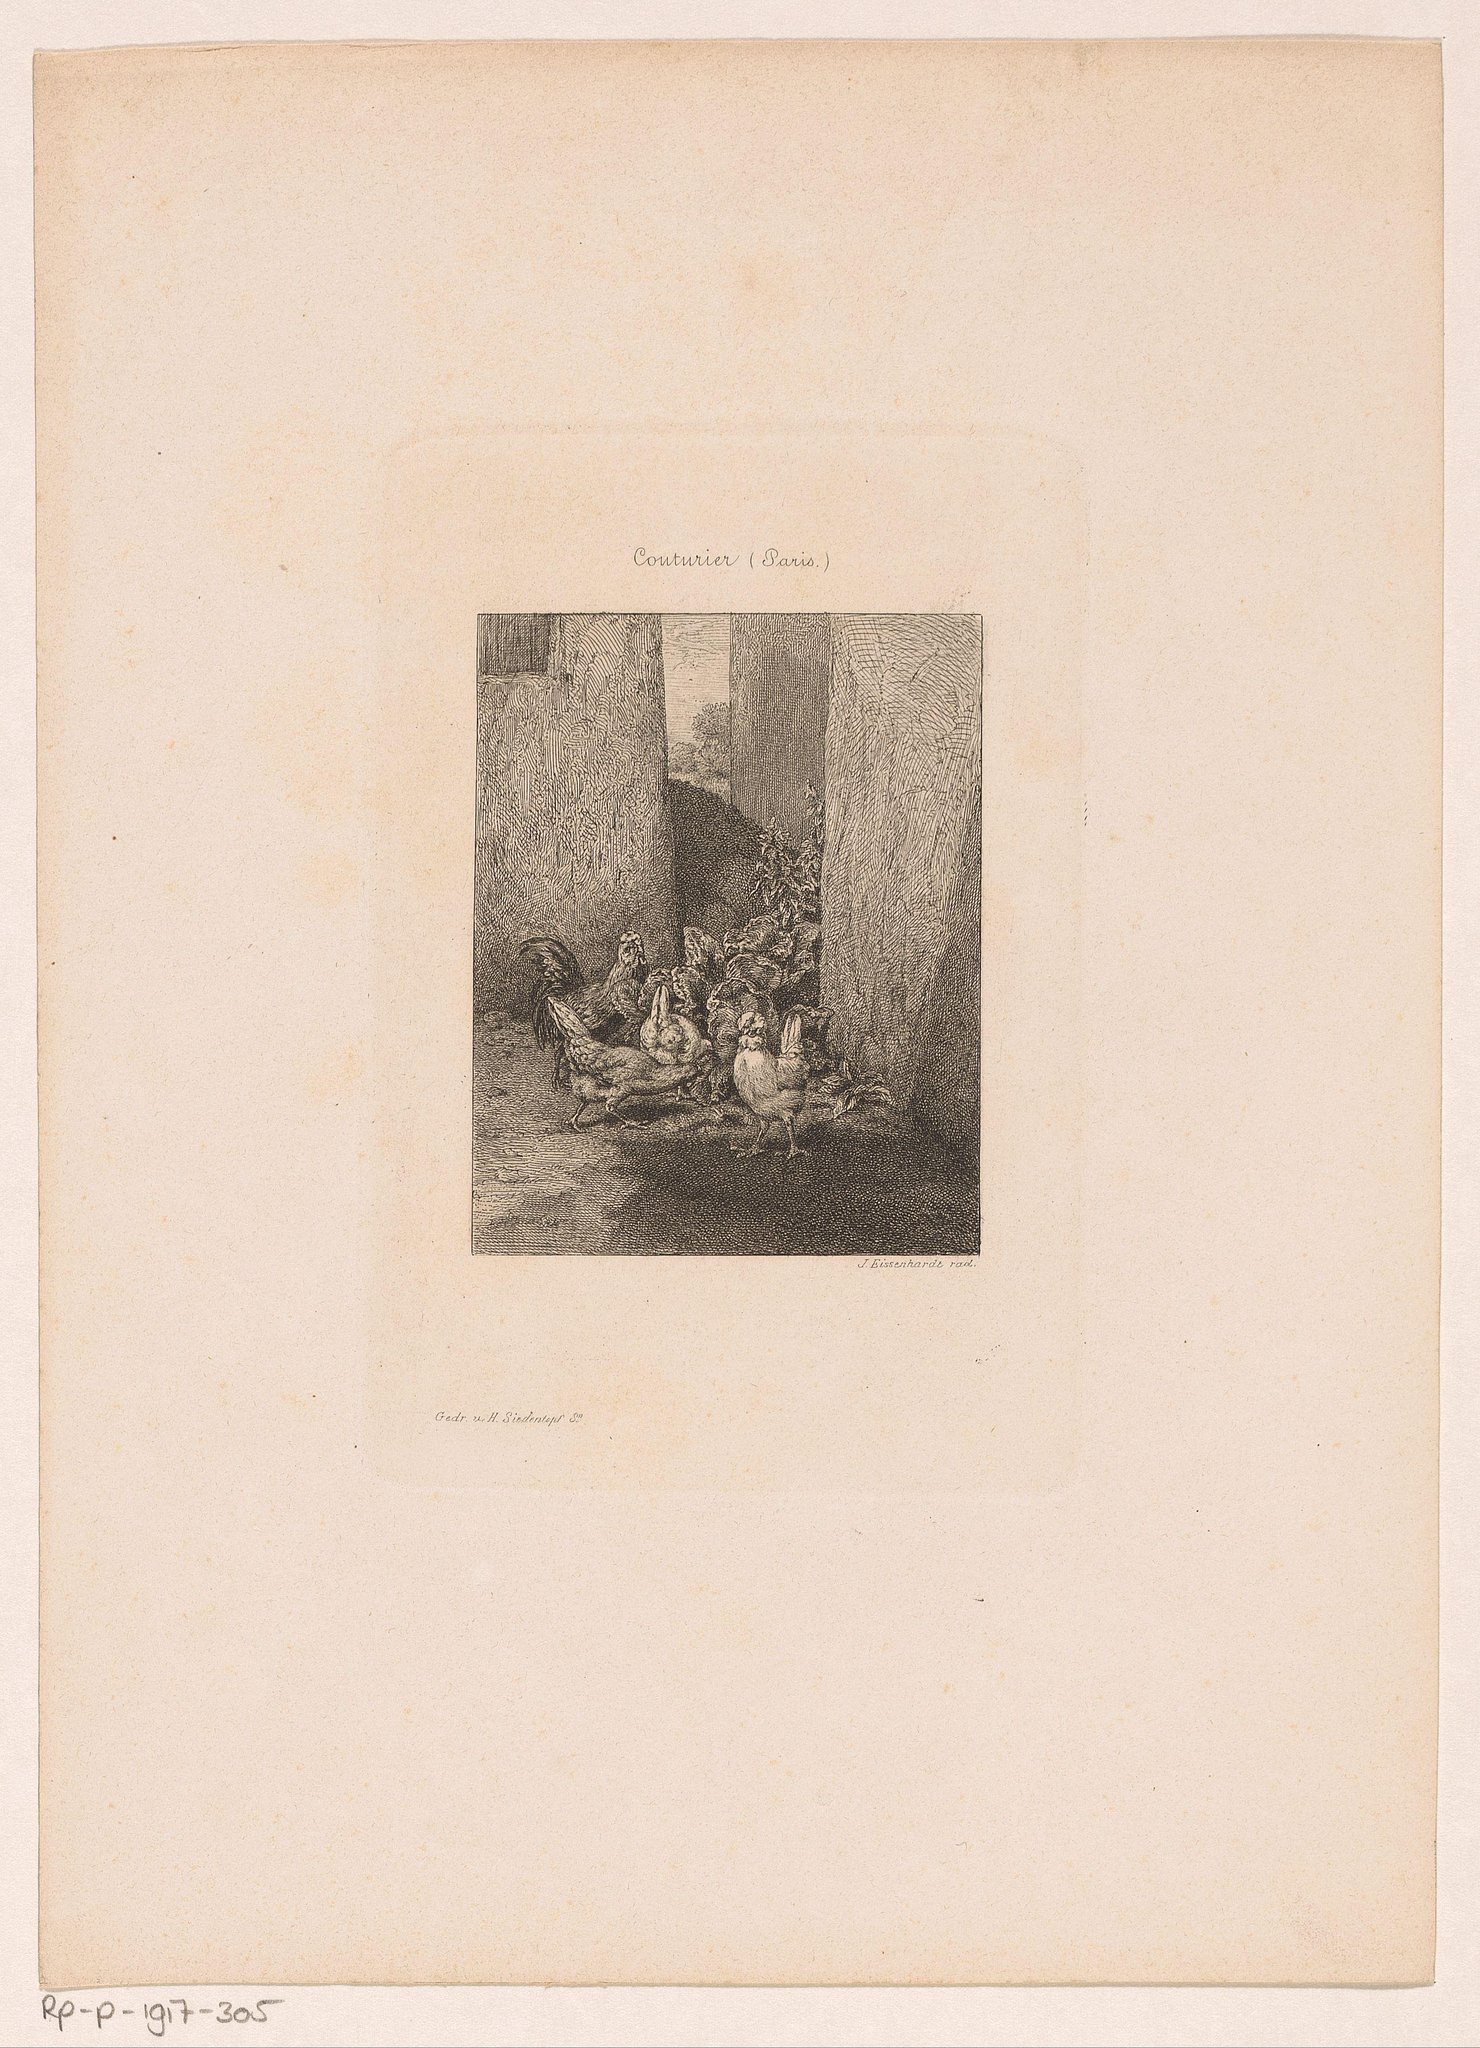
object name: print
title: Kippen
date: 1834-1896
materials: paper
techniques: etching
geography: paris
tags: fowl (cock, hen, chicken, etc.)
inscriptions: collector's mark: Lugt 2228